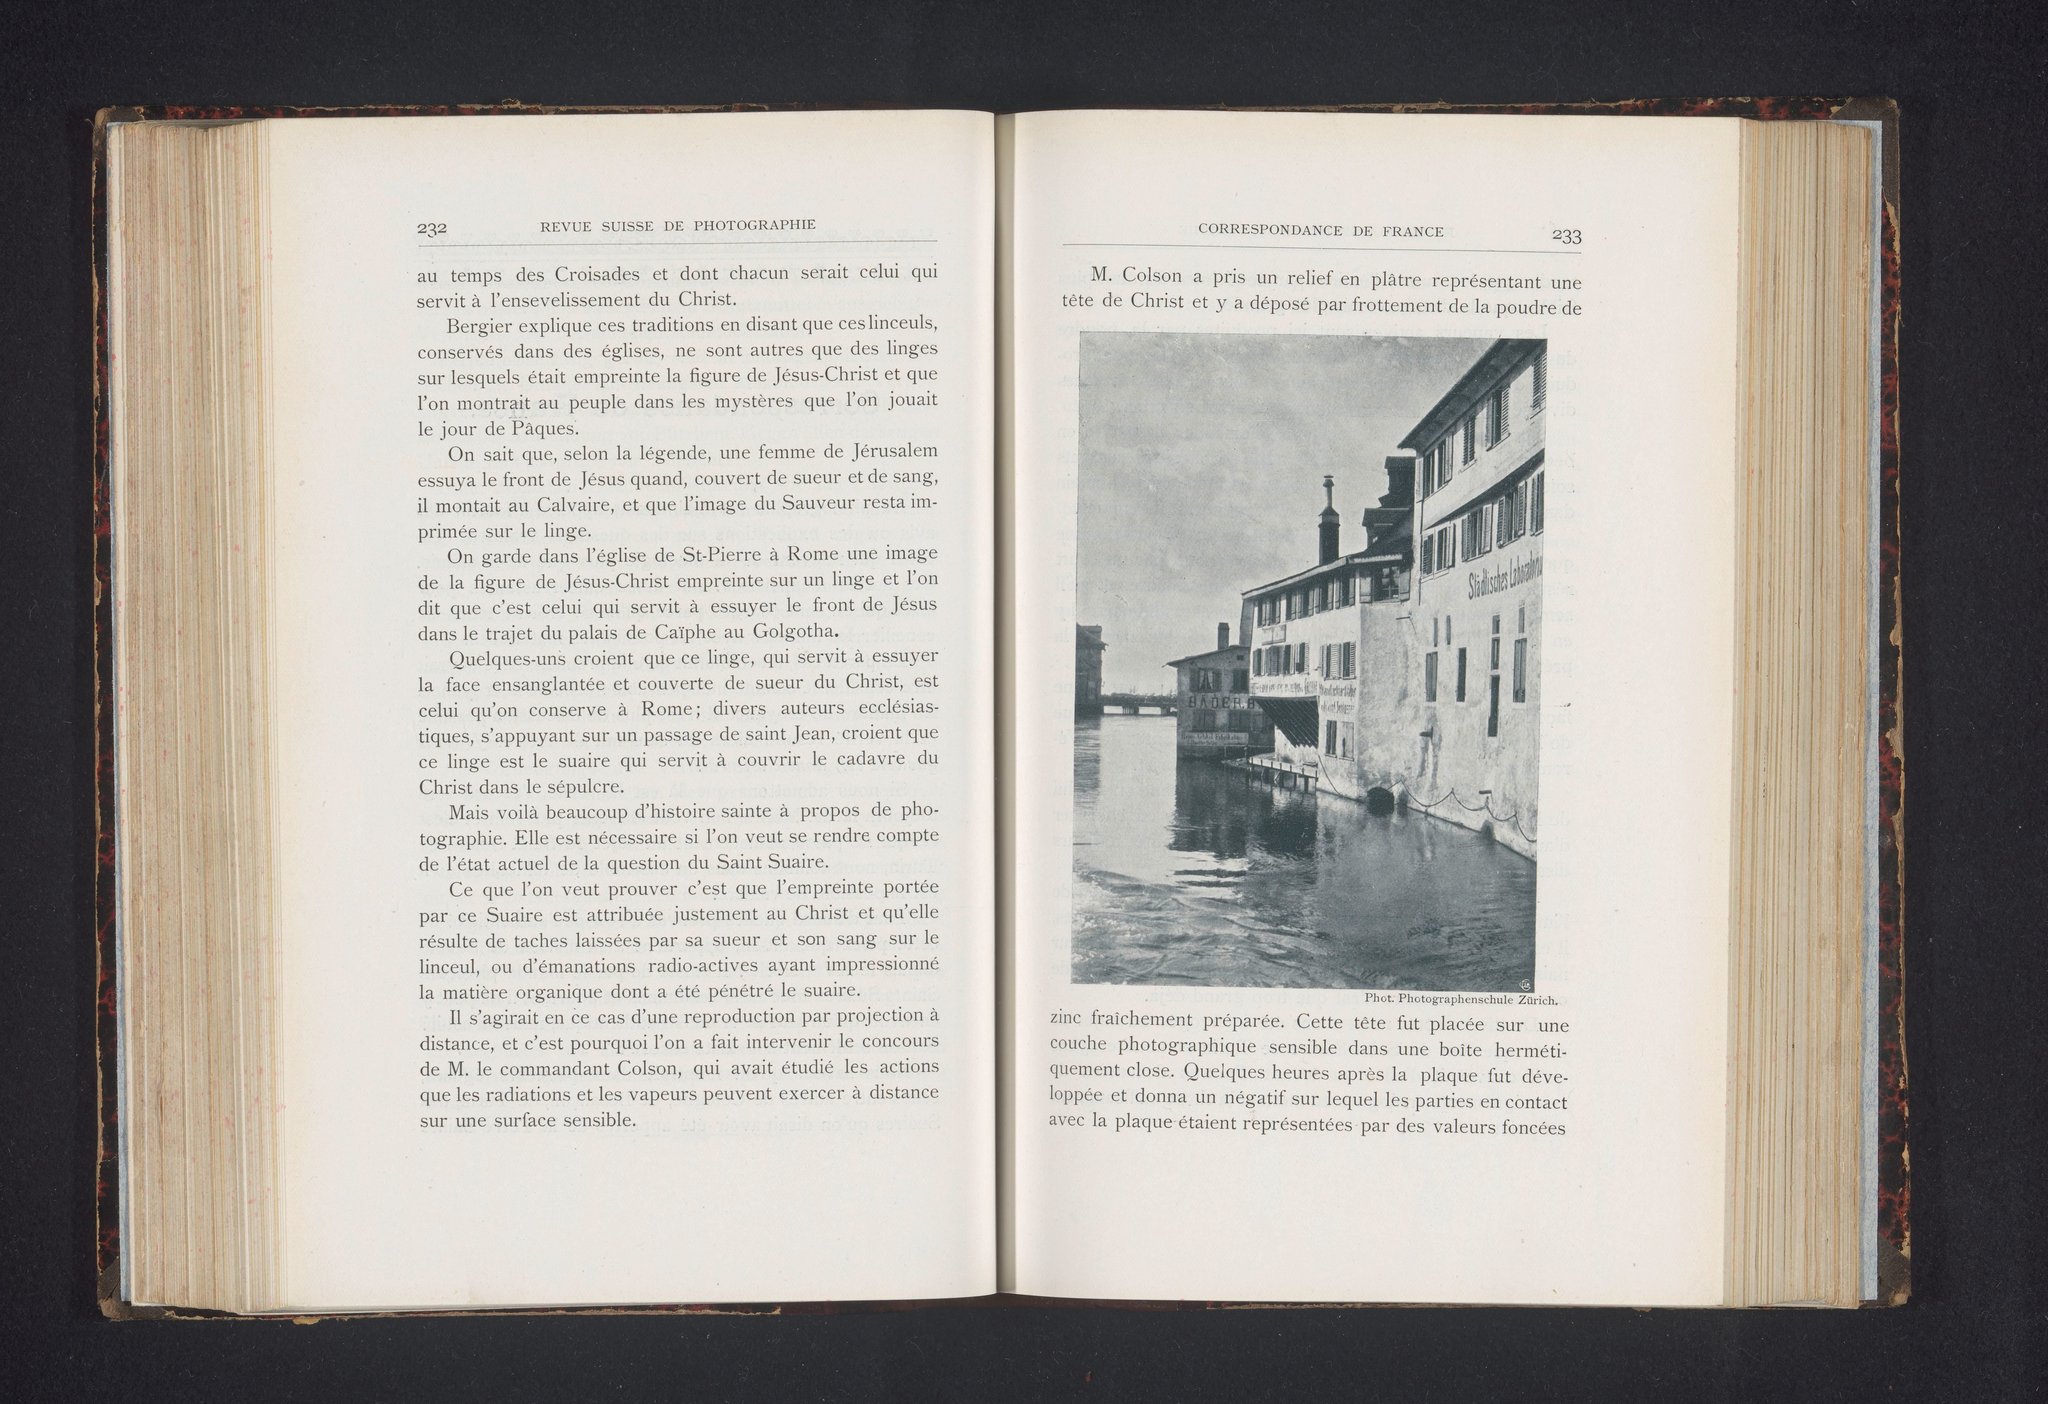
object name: photomechanical print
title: Stadsgezicht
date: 1897-1902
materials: paper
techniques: autotype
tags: city-view in general; 'veduta'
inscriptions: monogram: ‘C. Cie’